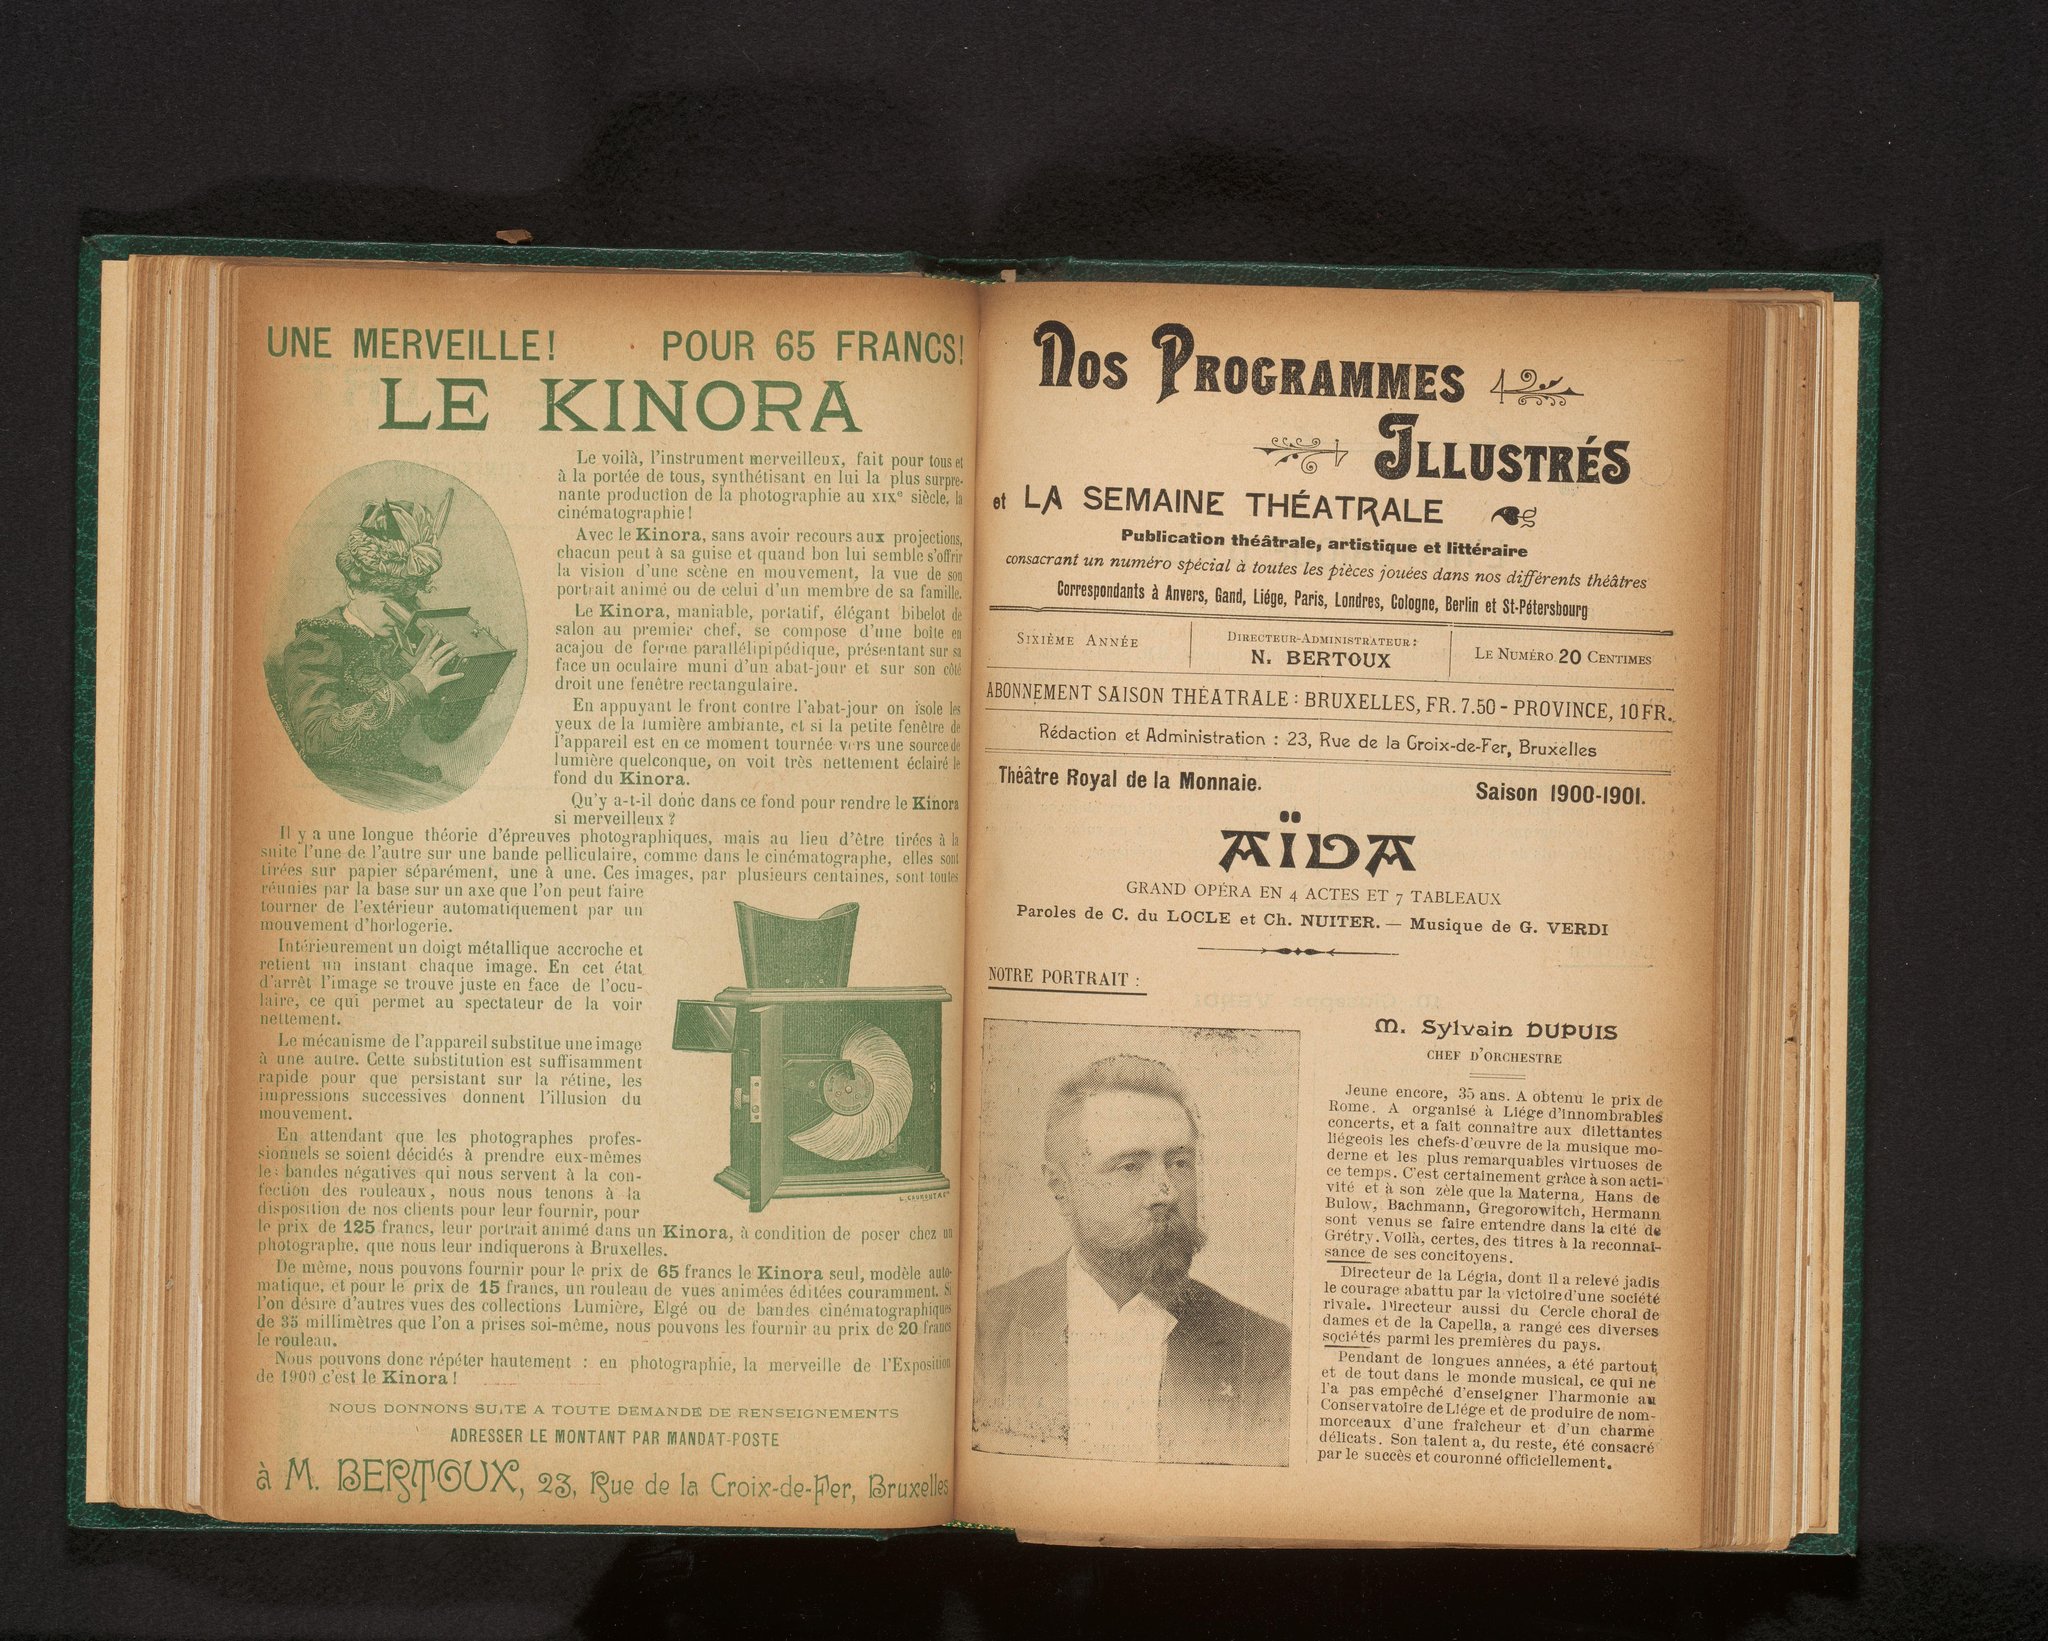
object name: page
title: M. Sylvain Dupuis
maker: Anonymous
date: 1895-1900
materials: paper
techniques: autotype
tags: liège, bruges, musician, adult man, historical persons